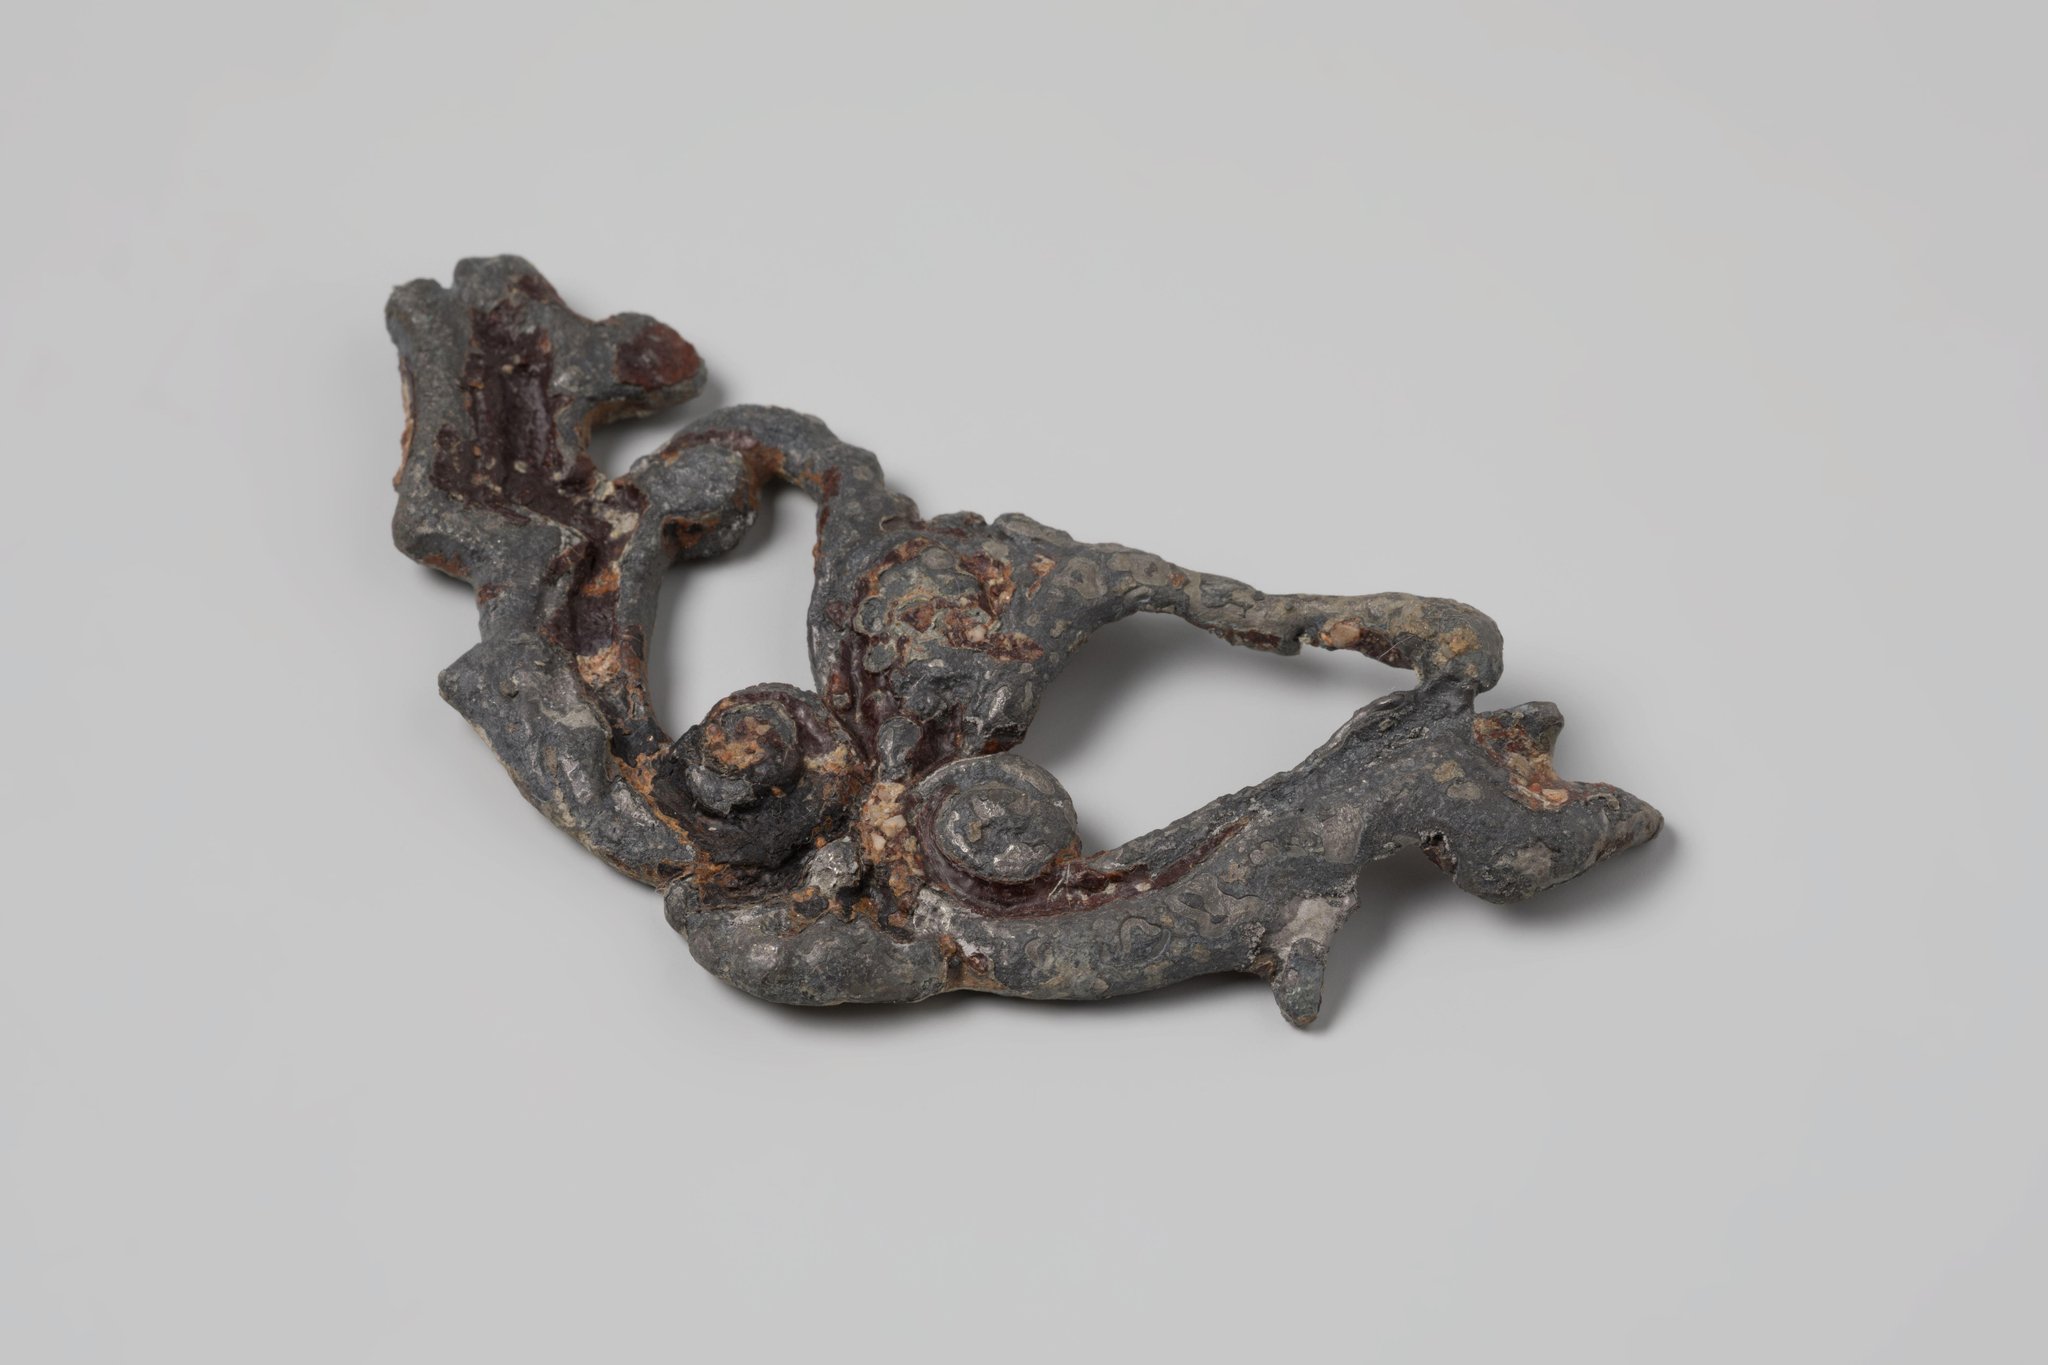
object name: beslag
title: Decoratief beslag uit het wrak van de Oost-Indiëvaarder Hollandia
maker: Anonymous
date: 1700-1743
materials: lead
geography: netherlands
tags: verenigde oostindische compagnie, hollandia (schip), annet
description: Fitting, decorative fitting or fragment; fragm, id. NG 1980-27H1133, scrolling ends of wings missing, eroded.